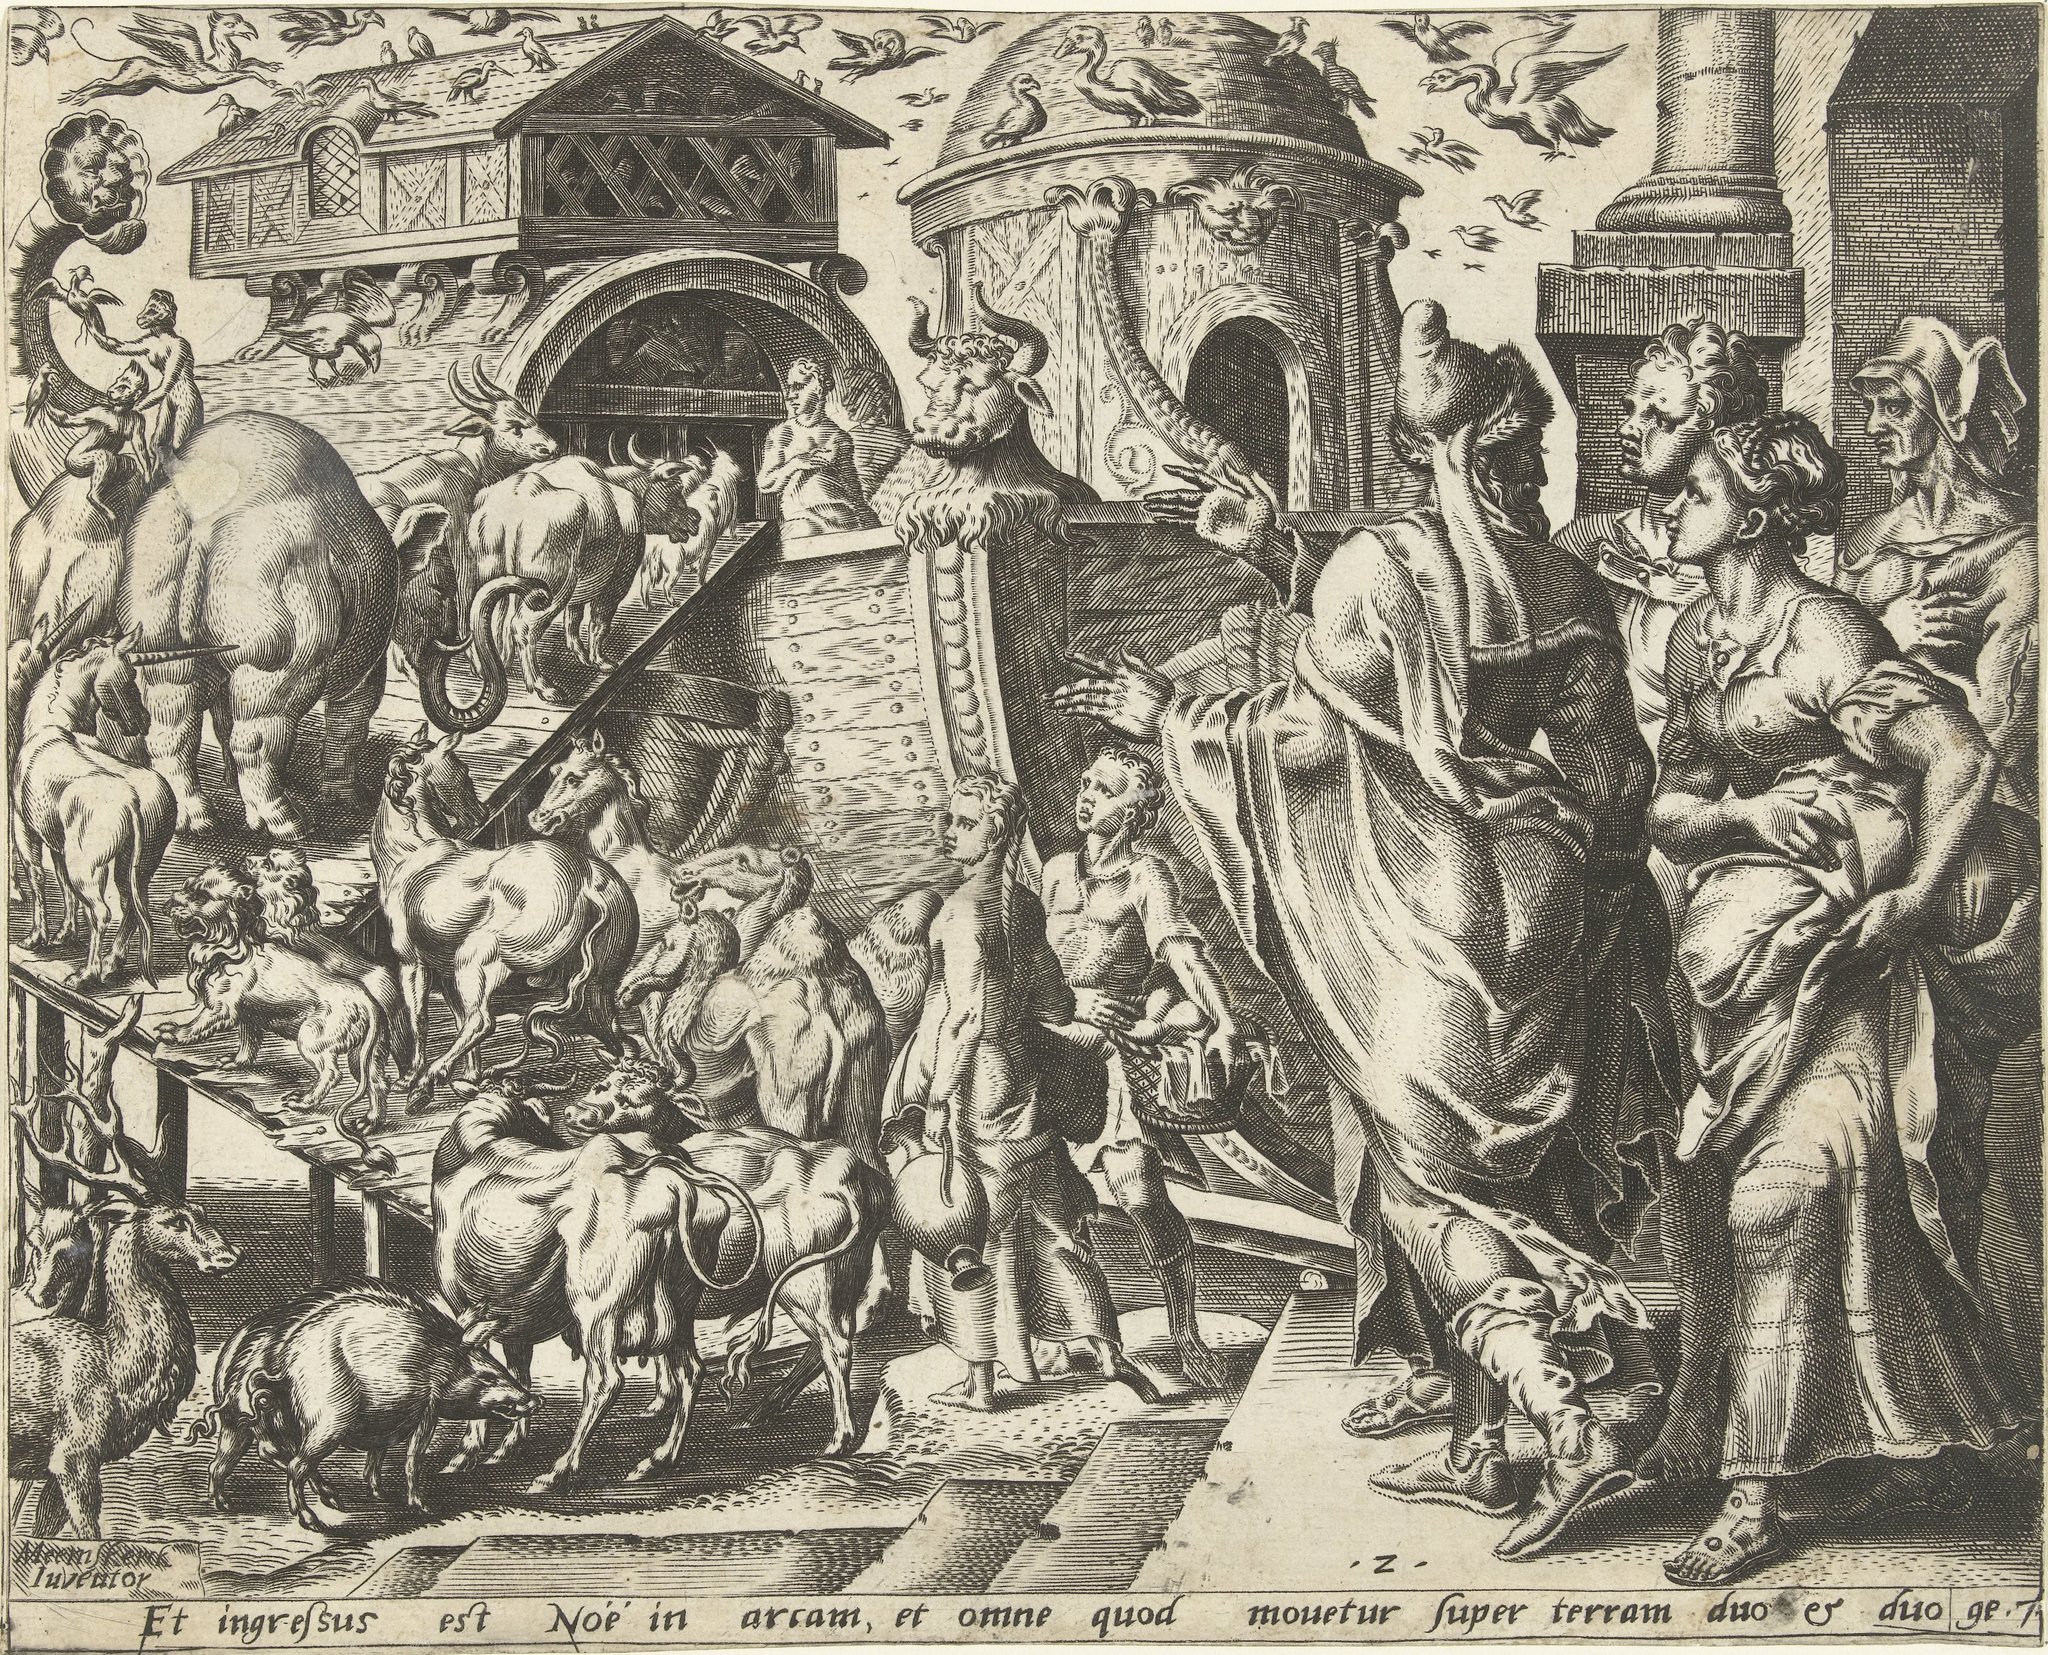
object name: print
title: De geschiedenis van Noach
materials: paper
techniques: engraving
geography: antwerp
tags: the animals enter the ark, noah and his family enter the ark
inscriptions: collector's mark: Lugt 2228, caption: ‘Et ingressus est noë in arcam, et omne quod super terram duo & duo ge.7’, number: ‘2’, signature: ‘MHeemskerck In[sic]ven[sic]tor’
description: Een stoet van dieren trekt de ark binnen, van elk soort een paar. Boven de ark een zwerm vogels. Rechtsvoor Noach en zijn familie.